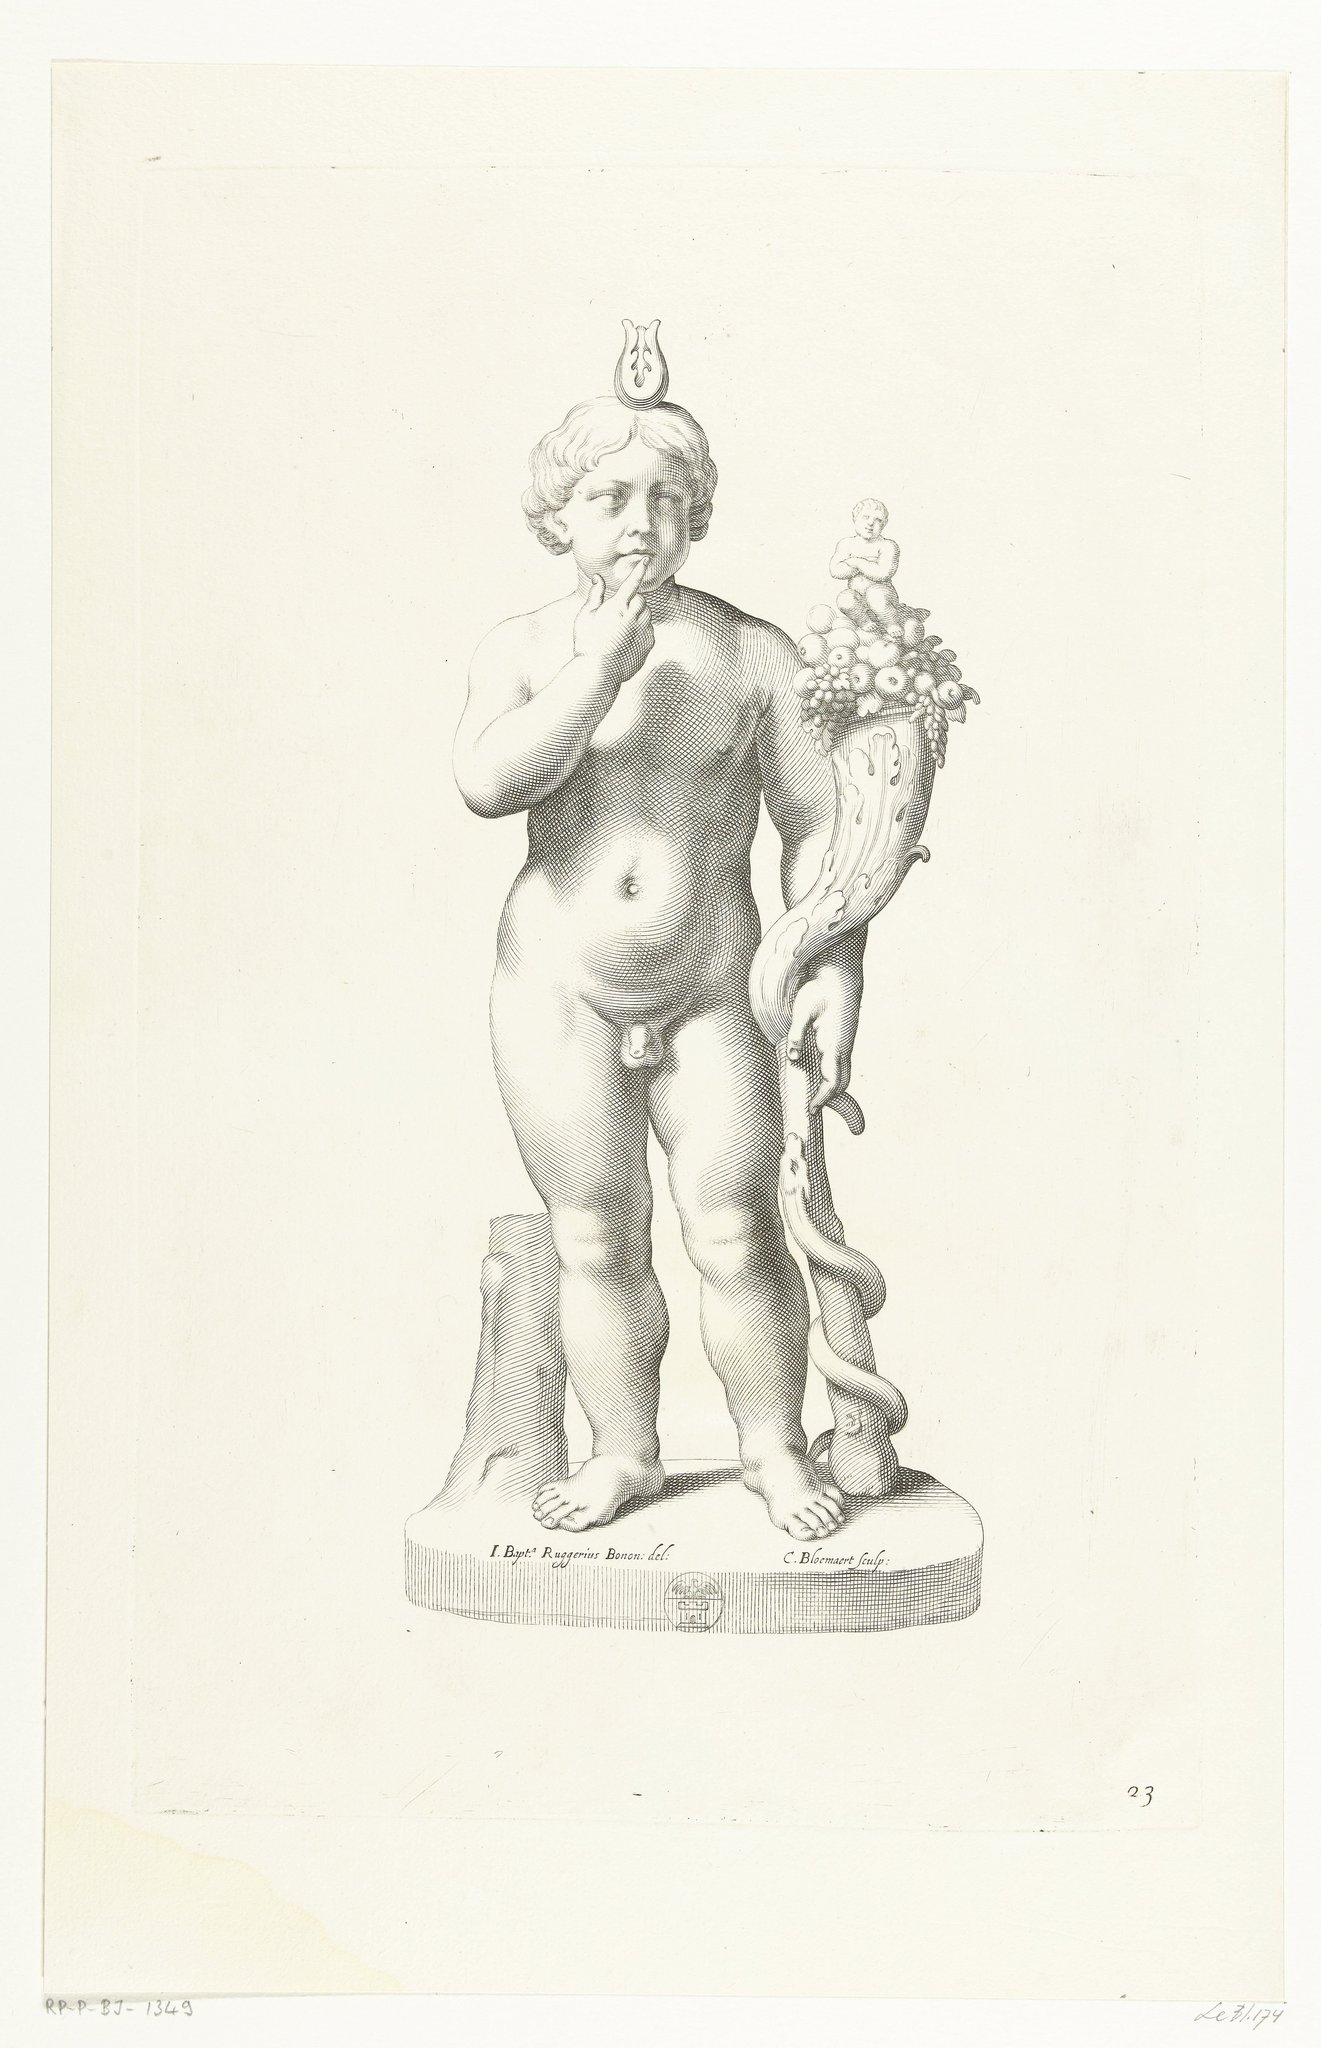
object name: print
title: Harpocrates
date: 1636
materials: paper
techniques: engraving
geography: rome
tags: putting a finger to the lips, 'silentium'; 'silentio' (ripa), piece of sculpture, reproduction of a piece of sculpture, harpocrates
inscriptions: number: ‘23’, collector's mark: Lugt 2228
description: Beeld van Harpocrates de Griekse god van de stilte. Een jongetje houdt zijn vinger voor zijn mond. Het beeld is afkomstig uit de collectie van Vincenzo Giustiniani, wiens wapen op de sokkel te zien is.